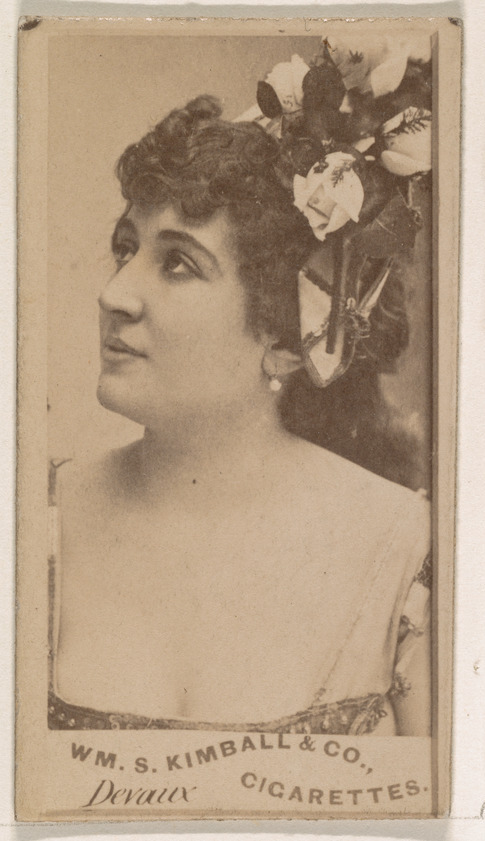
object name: photograph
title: Miss Devaux, from the Actresses series (N203) issued by Wm. S. Kimball & Co.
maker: william s. kimball & company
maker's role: publisher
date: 1889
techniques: color lithograph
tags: portraits,women,actresses